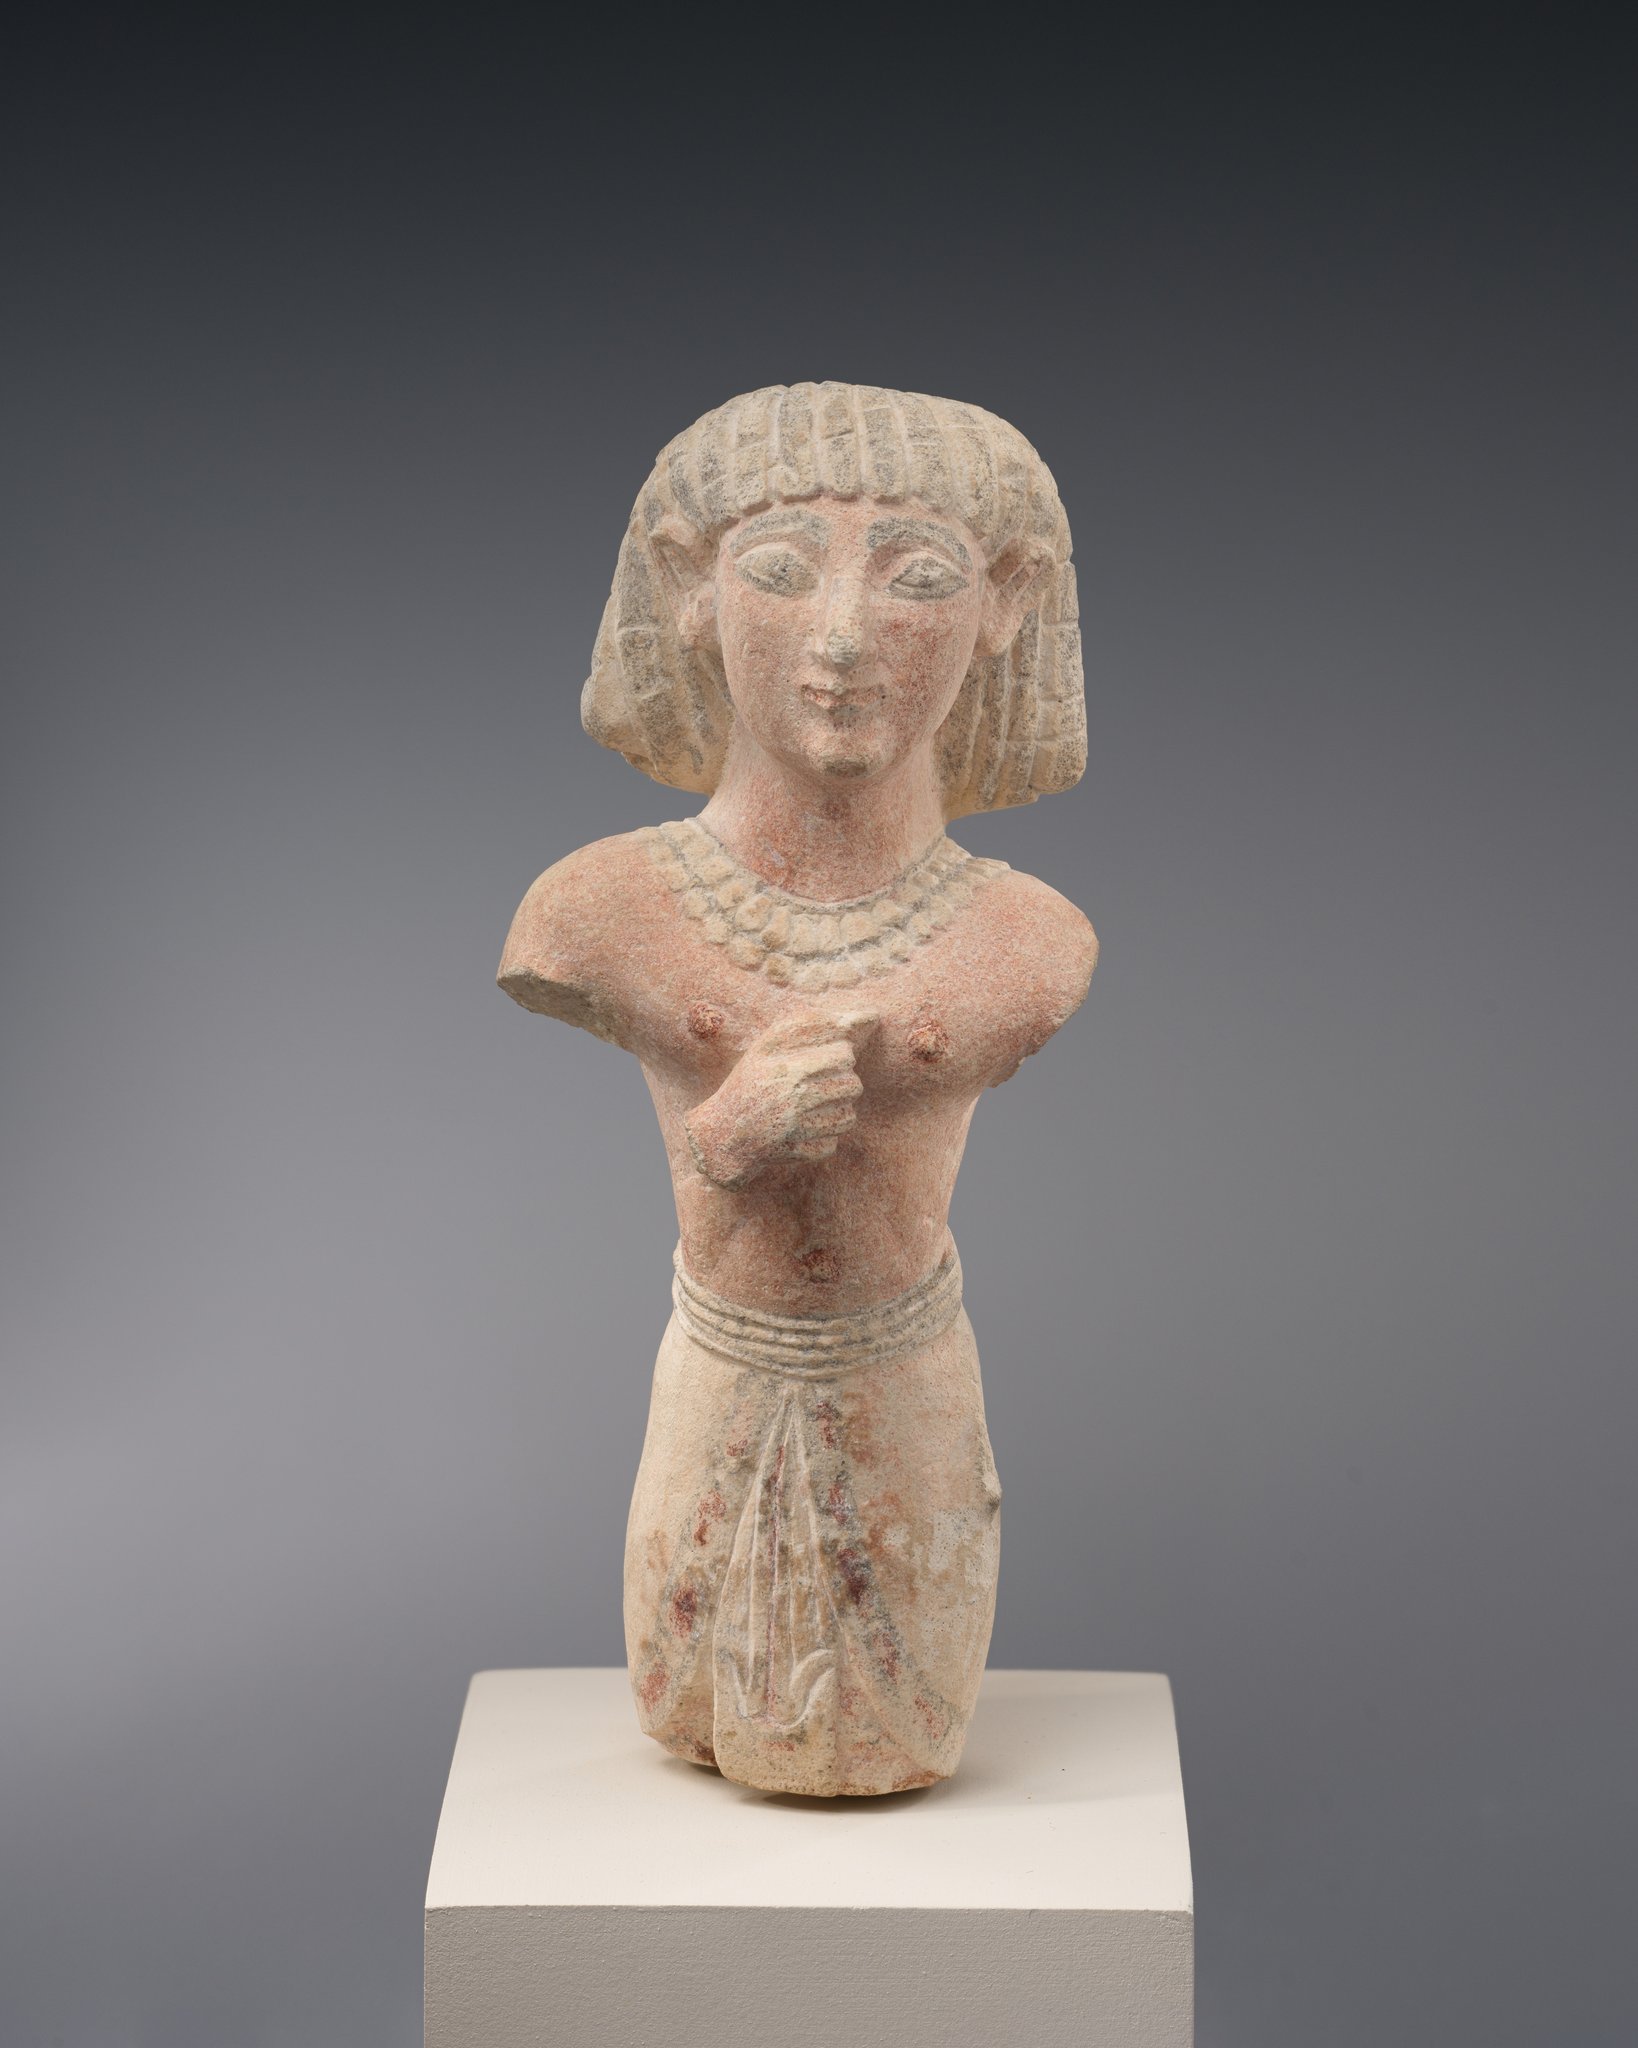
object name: statuette of a man in egyptian dress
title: Limestone youth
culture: cypriot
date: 600-568 BCE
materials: limestone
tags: men